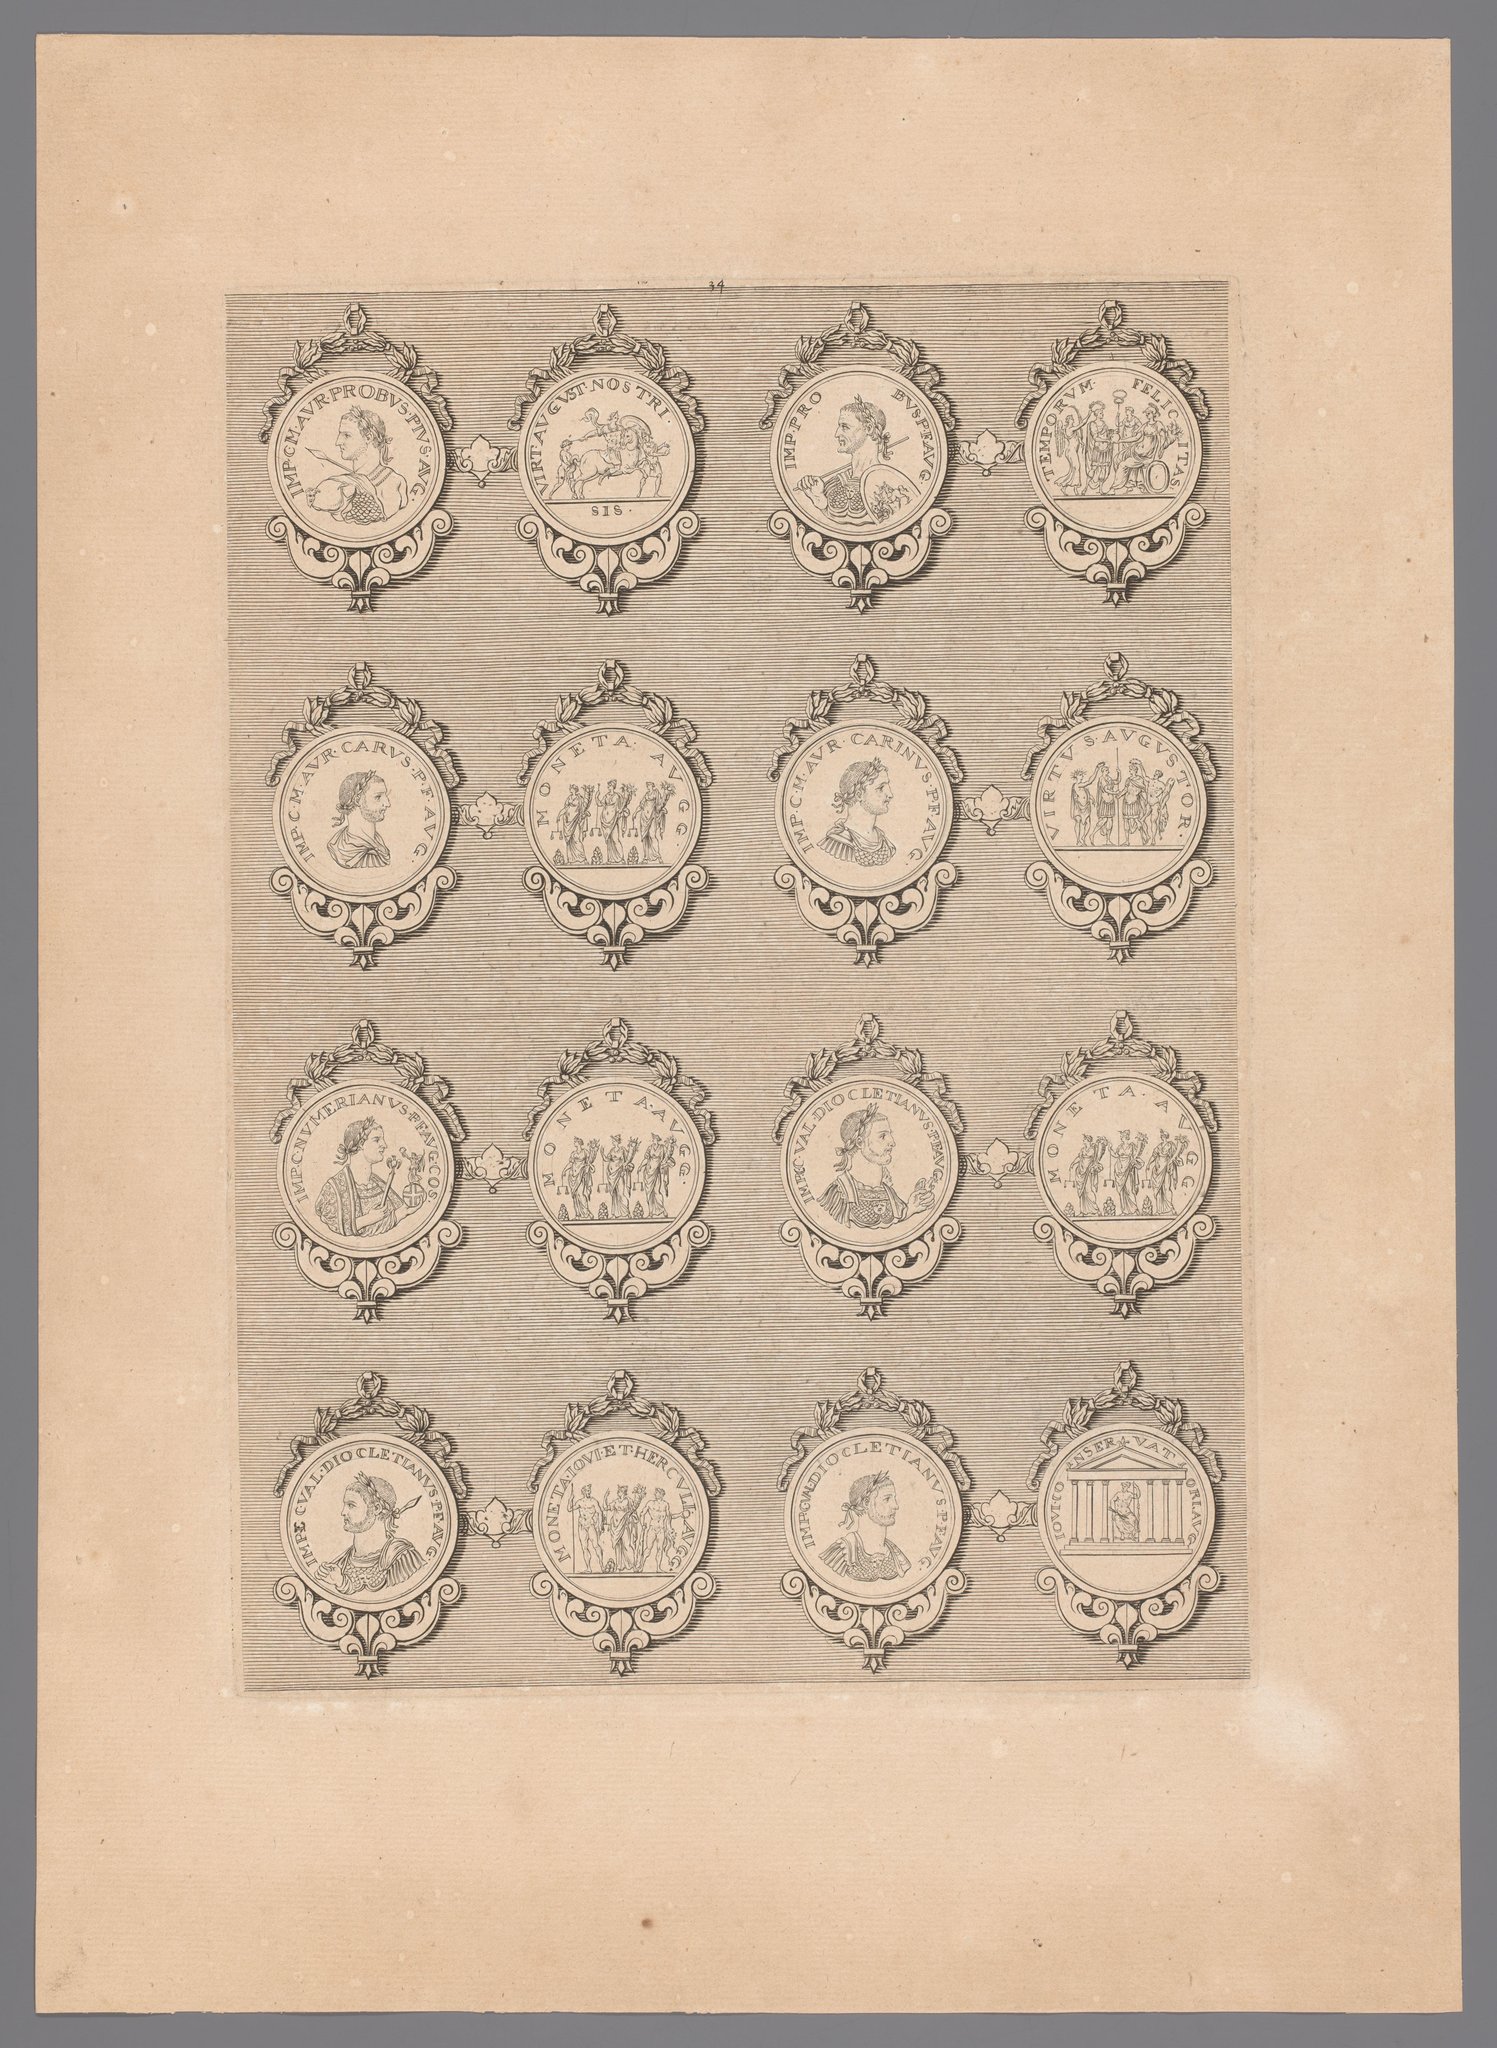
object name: print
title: Zestien penningen met versierde lijsten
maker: simon de la boissière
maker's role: print maker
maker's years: 1637-1682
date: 1647-1682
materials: paper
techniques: etching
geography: france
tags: medal (considered as a piece of sculpture, regardless of its specific function)